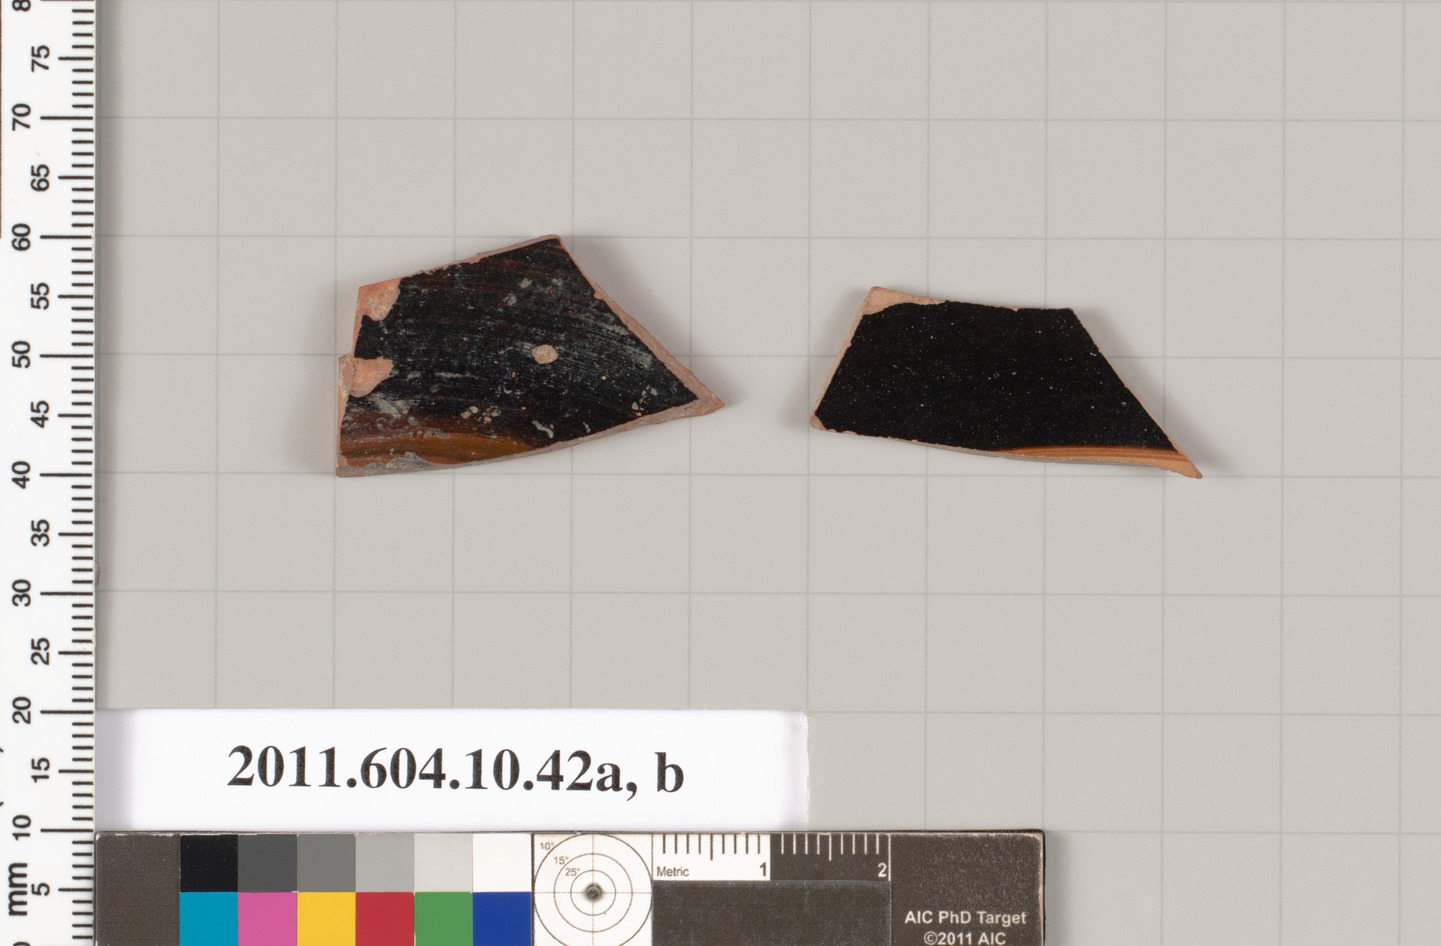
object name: kylix fragment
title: Terracotta fragments of kylikes (drinking cups)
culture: etruscan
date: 334-301 BCE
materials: terracotta